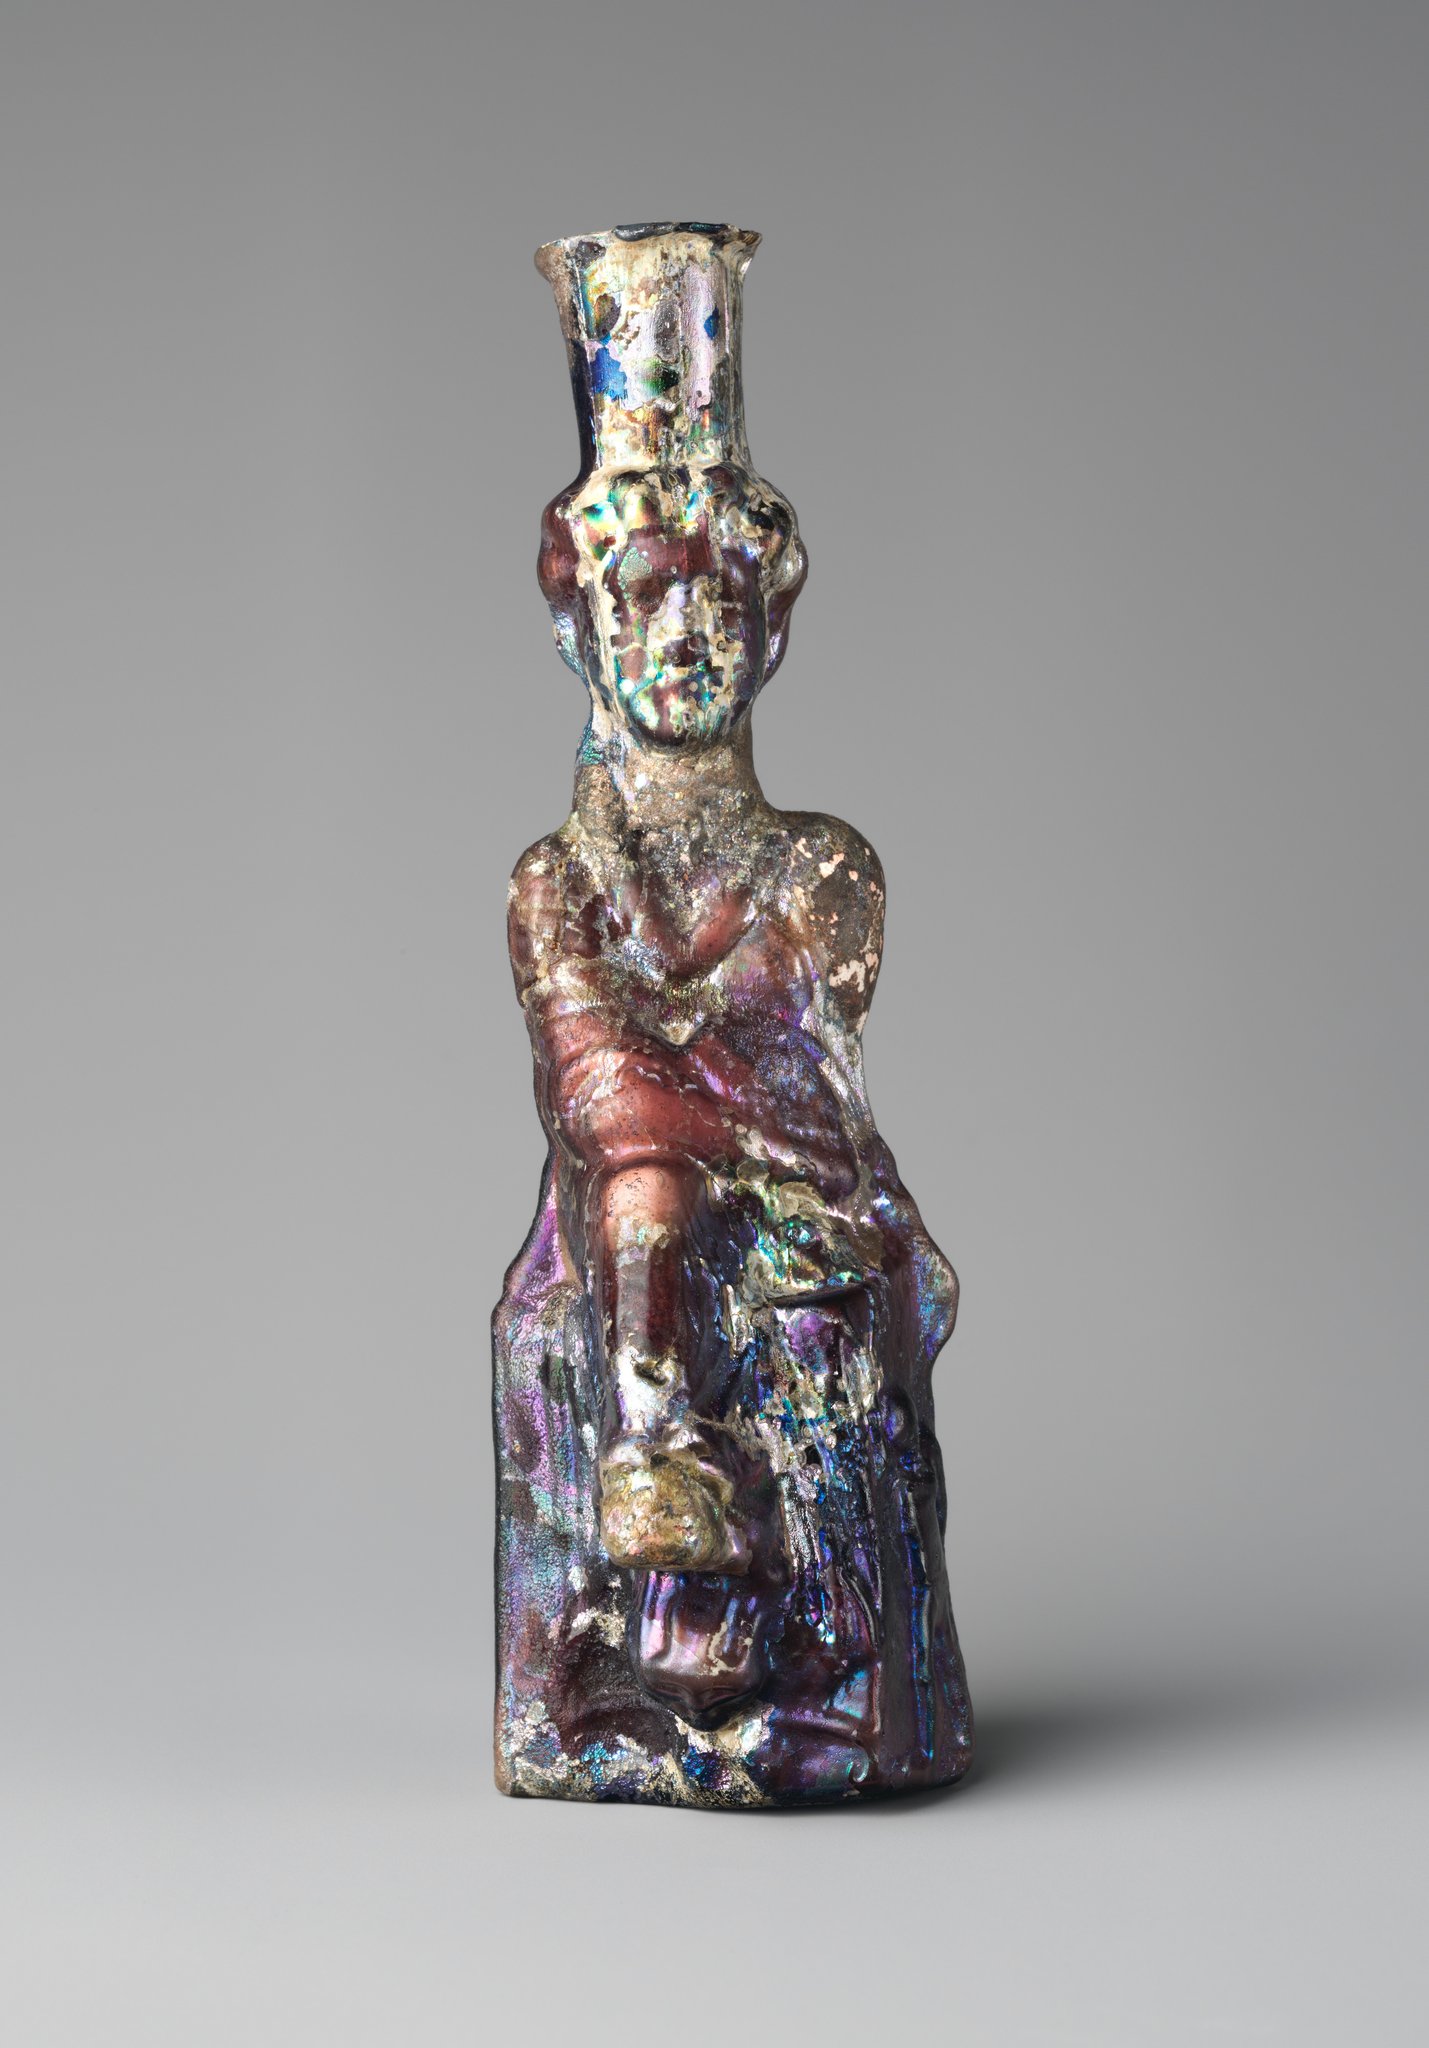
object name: bottle in the form of a statuette of antiocheia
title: Glass bottle in the form of Tyche (Good Fortune)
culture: roman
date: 101-300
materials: glass